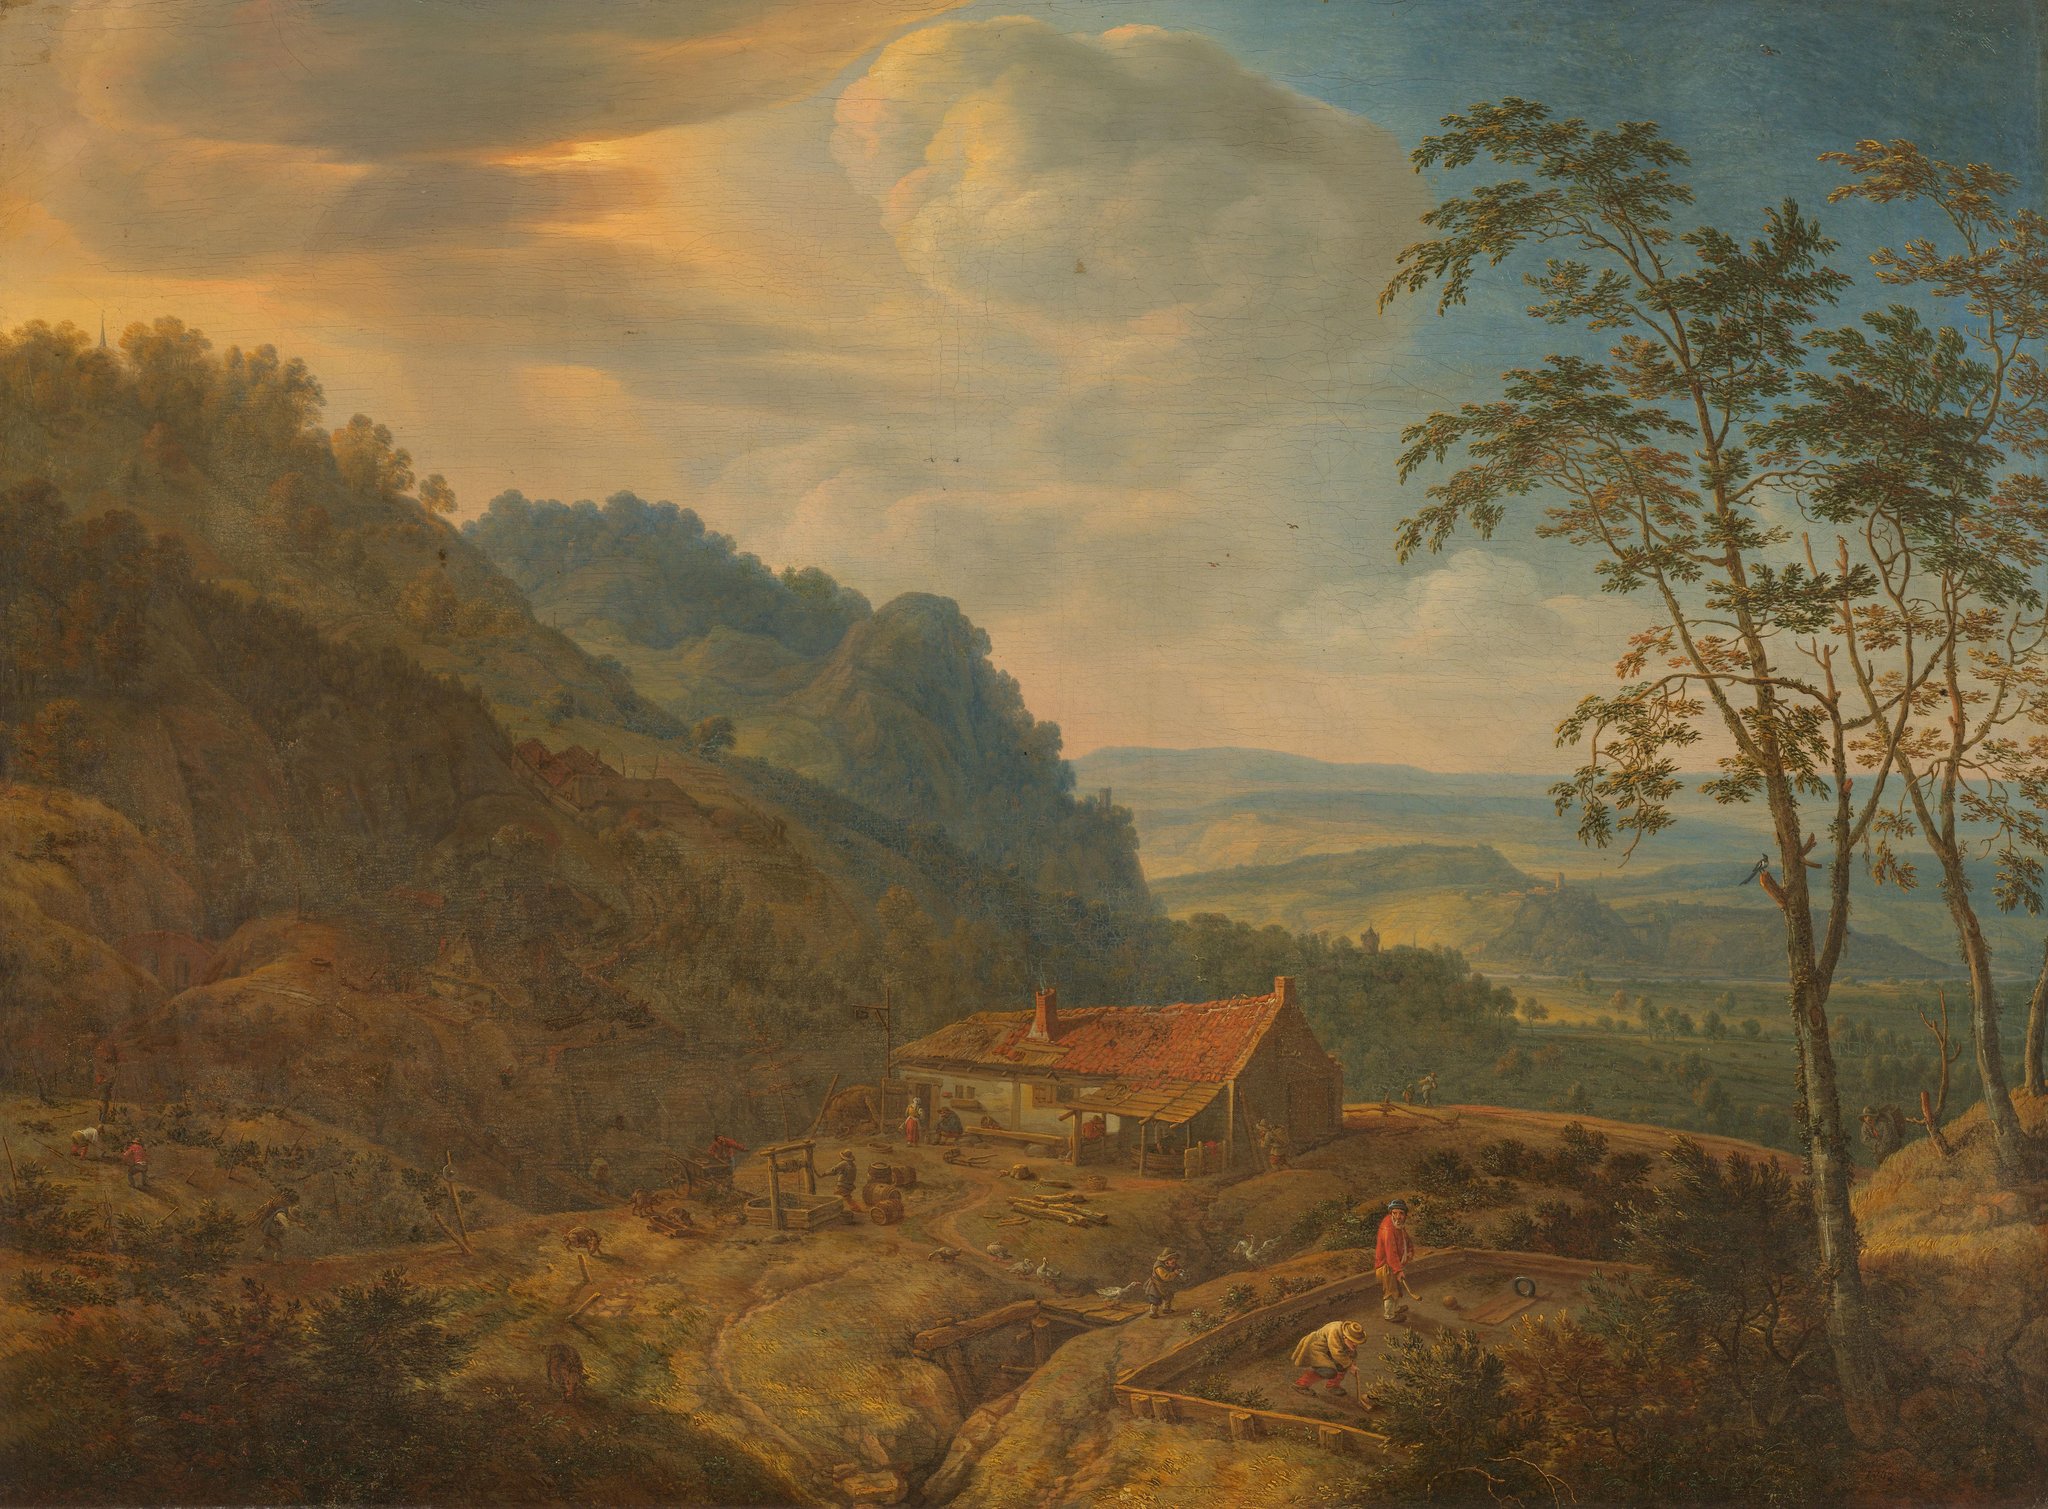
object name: painting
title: Mountainous Landscape with Farm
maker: herman saftleven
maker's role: draughtsman, painter, print maker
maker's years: 1609-1685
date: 1663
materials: canvas, oil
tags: (high) hill, farm or solitary house in landscape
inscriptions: signature and date, with ligated monogram, lower right: ‘HS / 1663’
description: Berglandschap met een boerderij of een herberg gelegen aan een landweg. Rechts twee kolfspelers op een baan. Voor de herberg staat een man bij de waterput, een ander perst druiven. In het omringend landschap zijn werklieden bezig met houthakken, hier en daar liggen meer boerderijen.